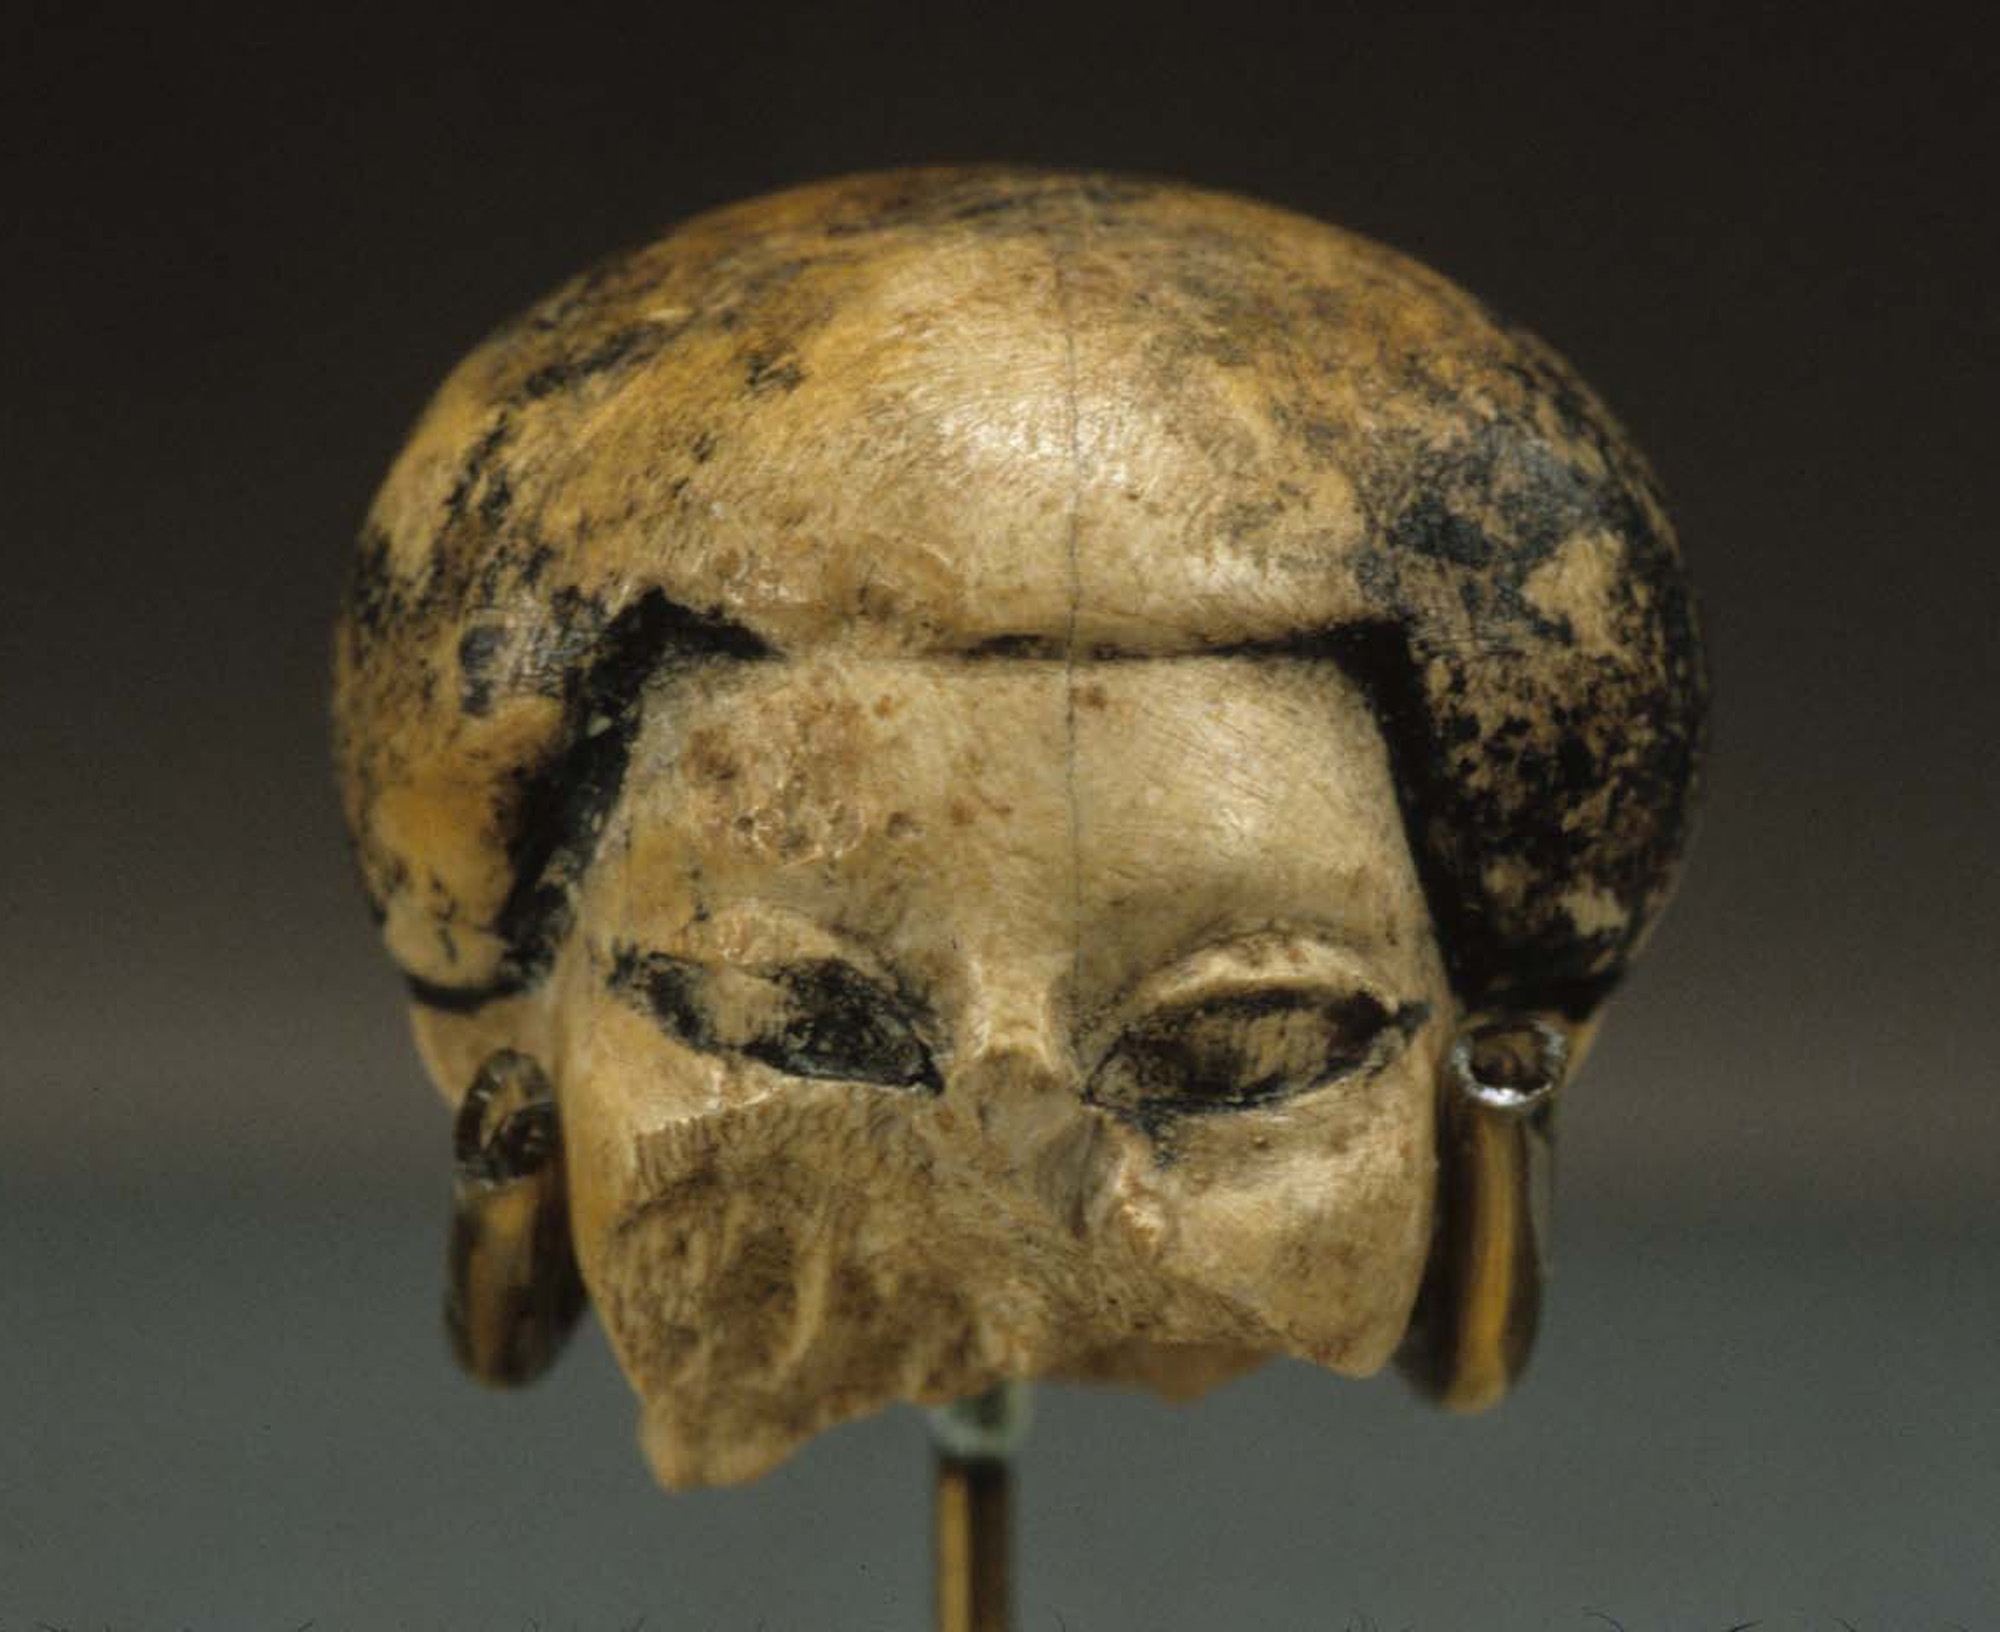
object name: head, statuette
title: Head of statuette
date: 1700-1550 BCE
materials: ivory, paint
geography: egypt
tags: heads